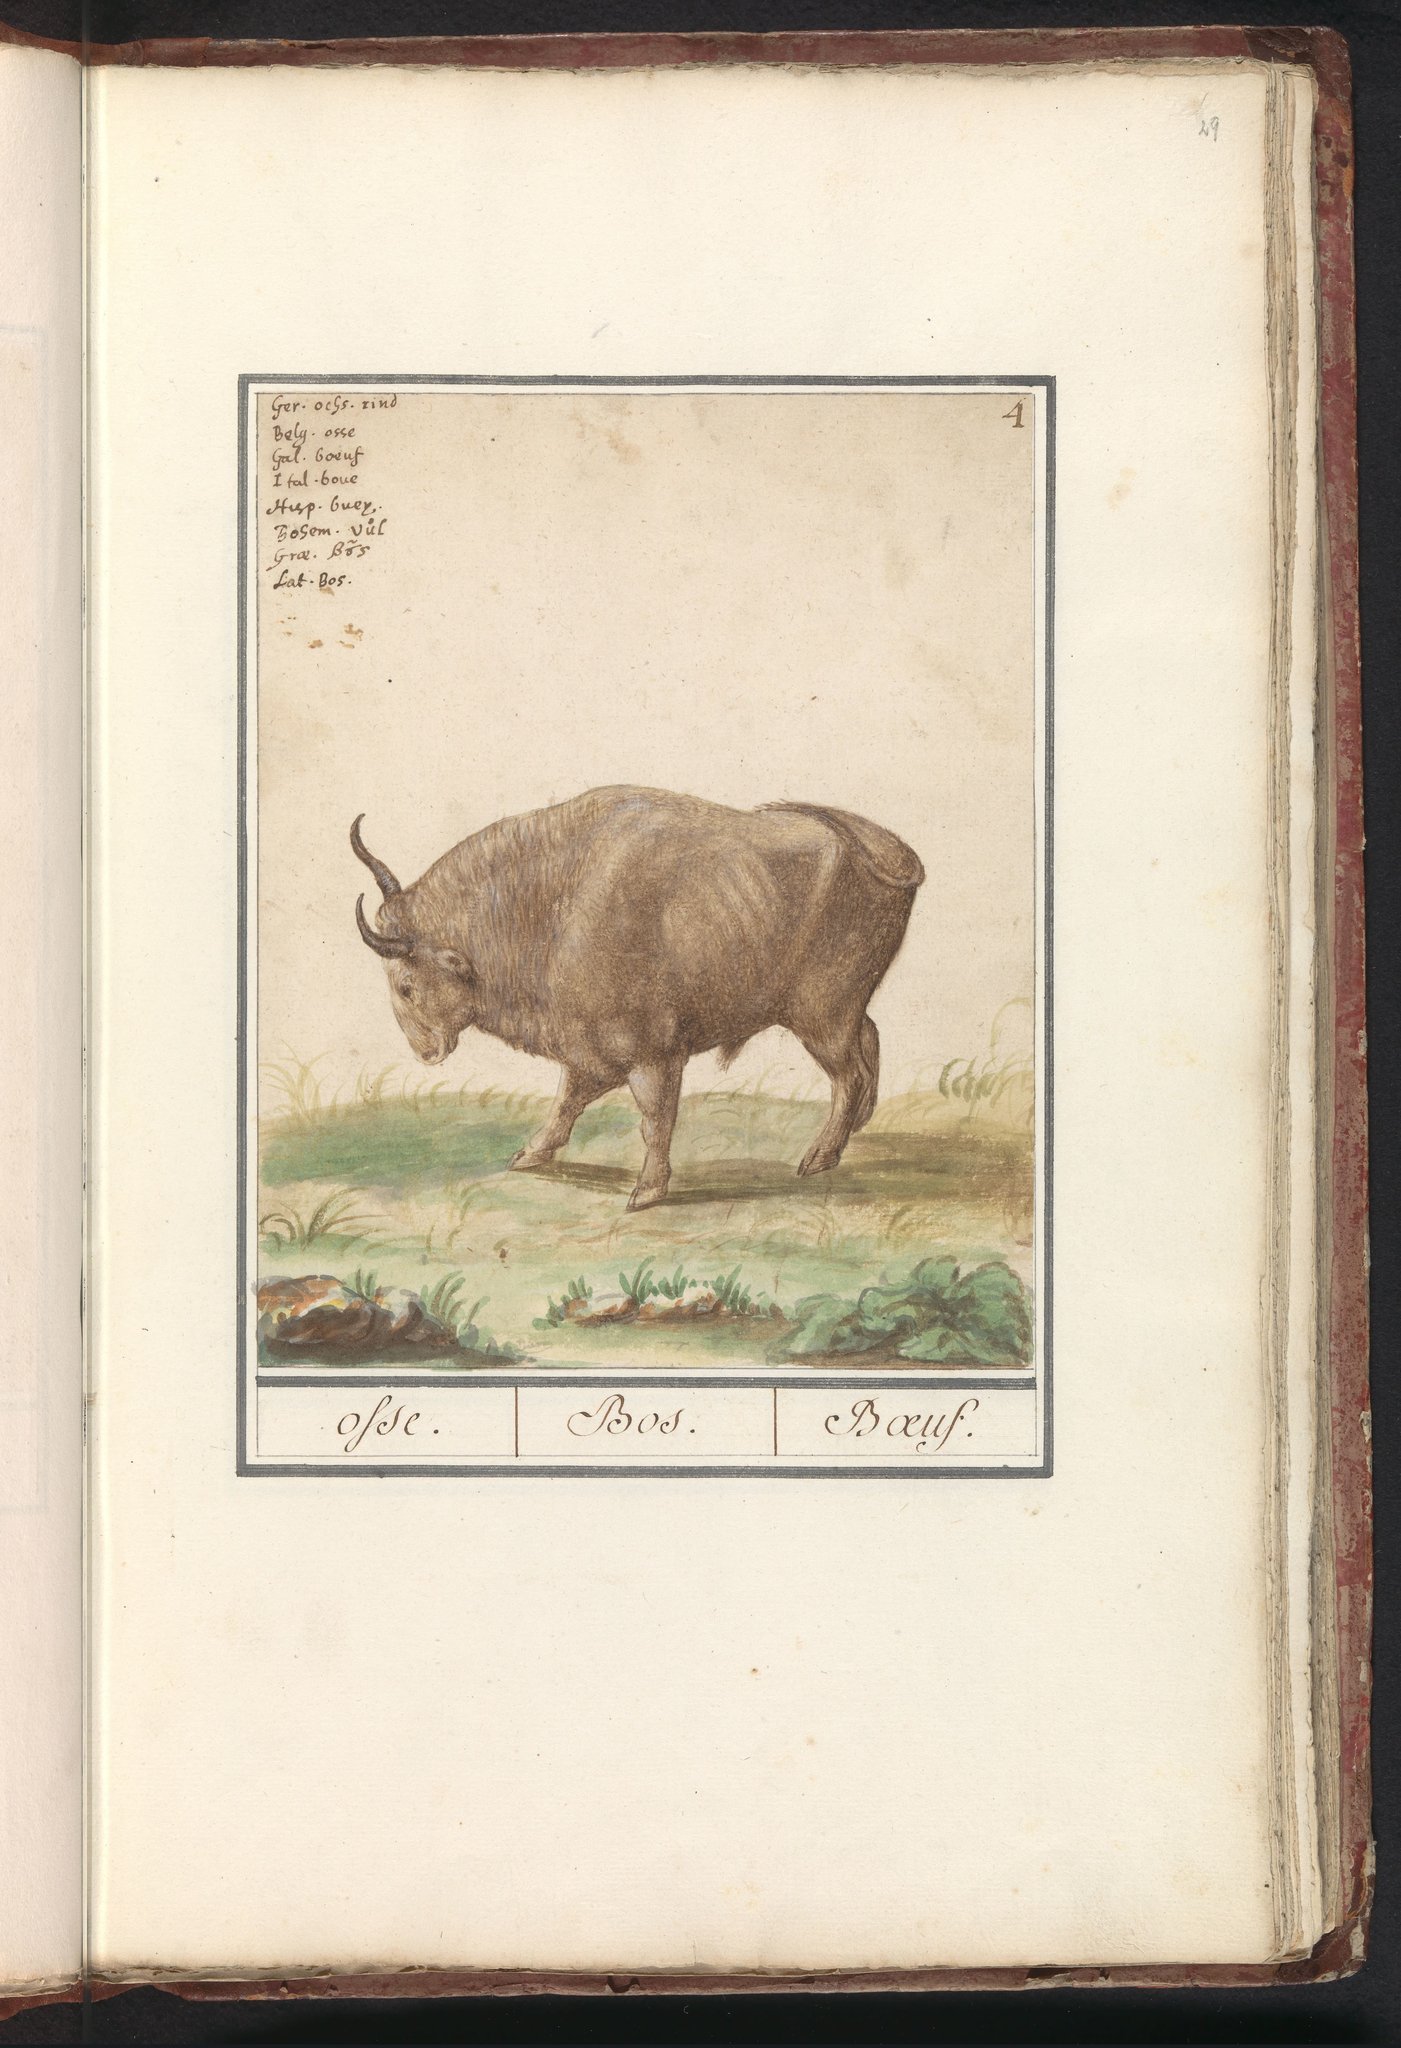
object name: drawing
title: Os (Bos taurus)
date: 1596-1610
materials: paint, ink, paper, watercolor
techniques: brush, pen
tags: ox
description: Os. Genummerd rechtsboven: 4. Linksboven de naam in acht talen. Onderdeel van het eerste album met tekeningen van viervoeters. Eerste van twaalf albums met tekeningen van dieren, vogels en planten bekend rond 1600, gemaakt in opdracht van keizer Rudolf II. Met toelichting in Nederlands, Latijn en Frans.